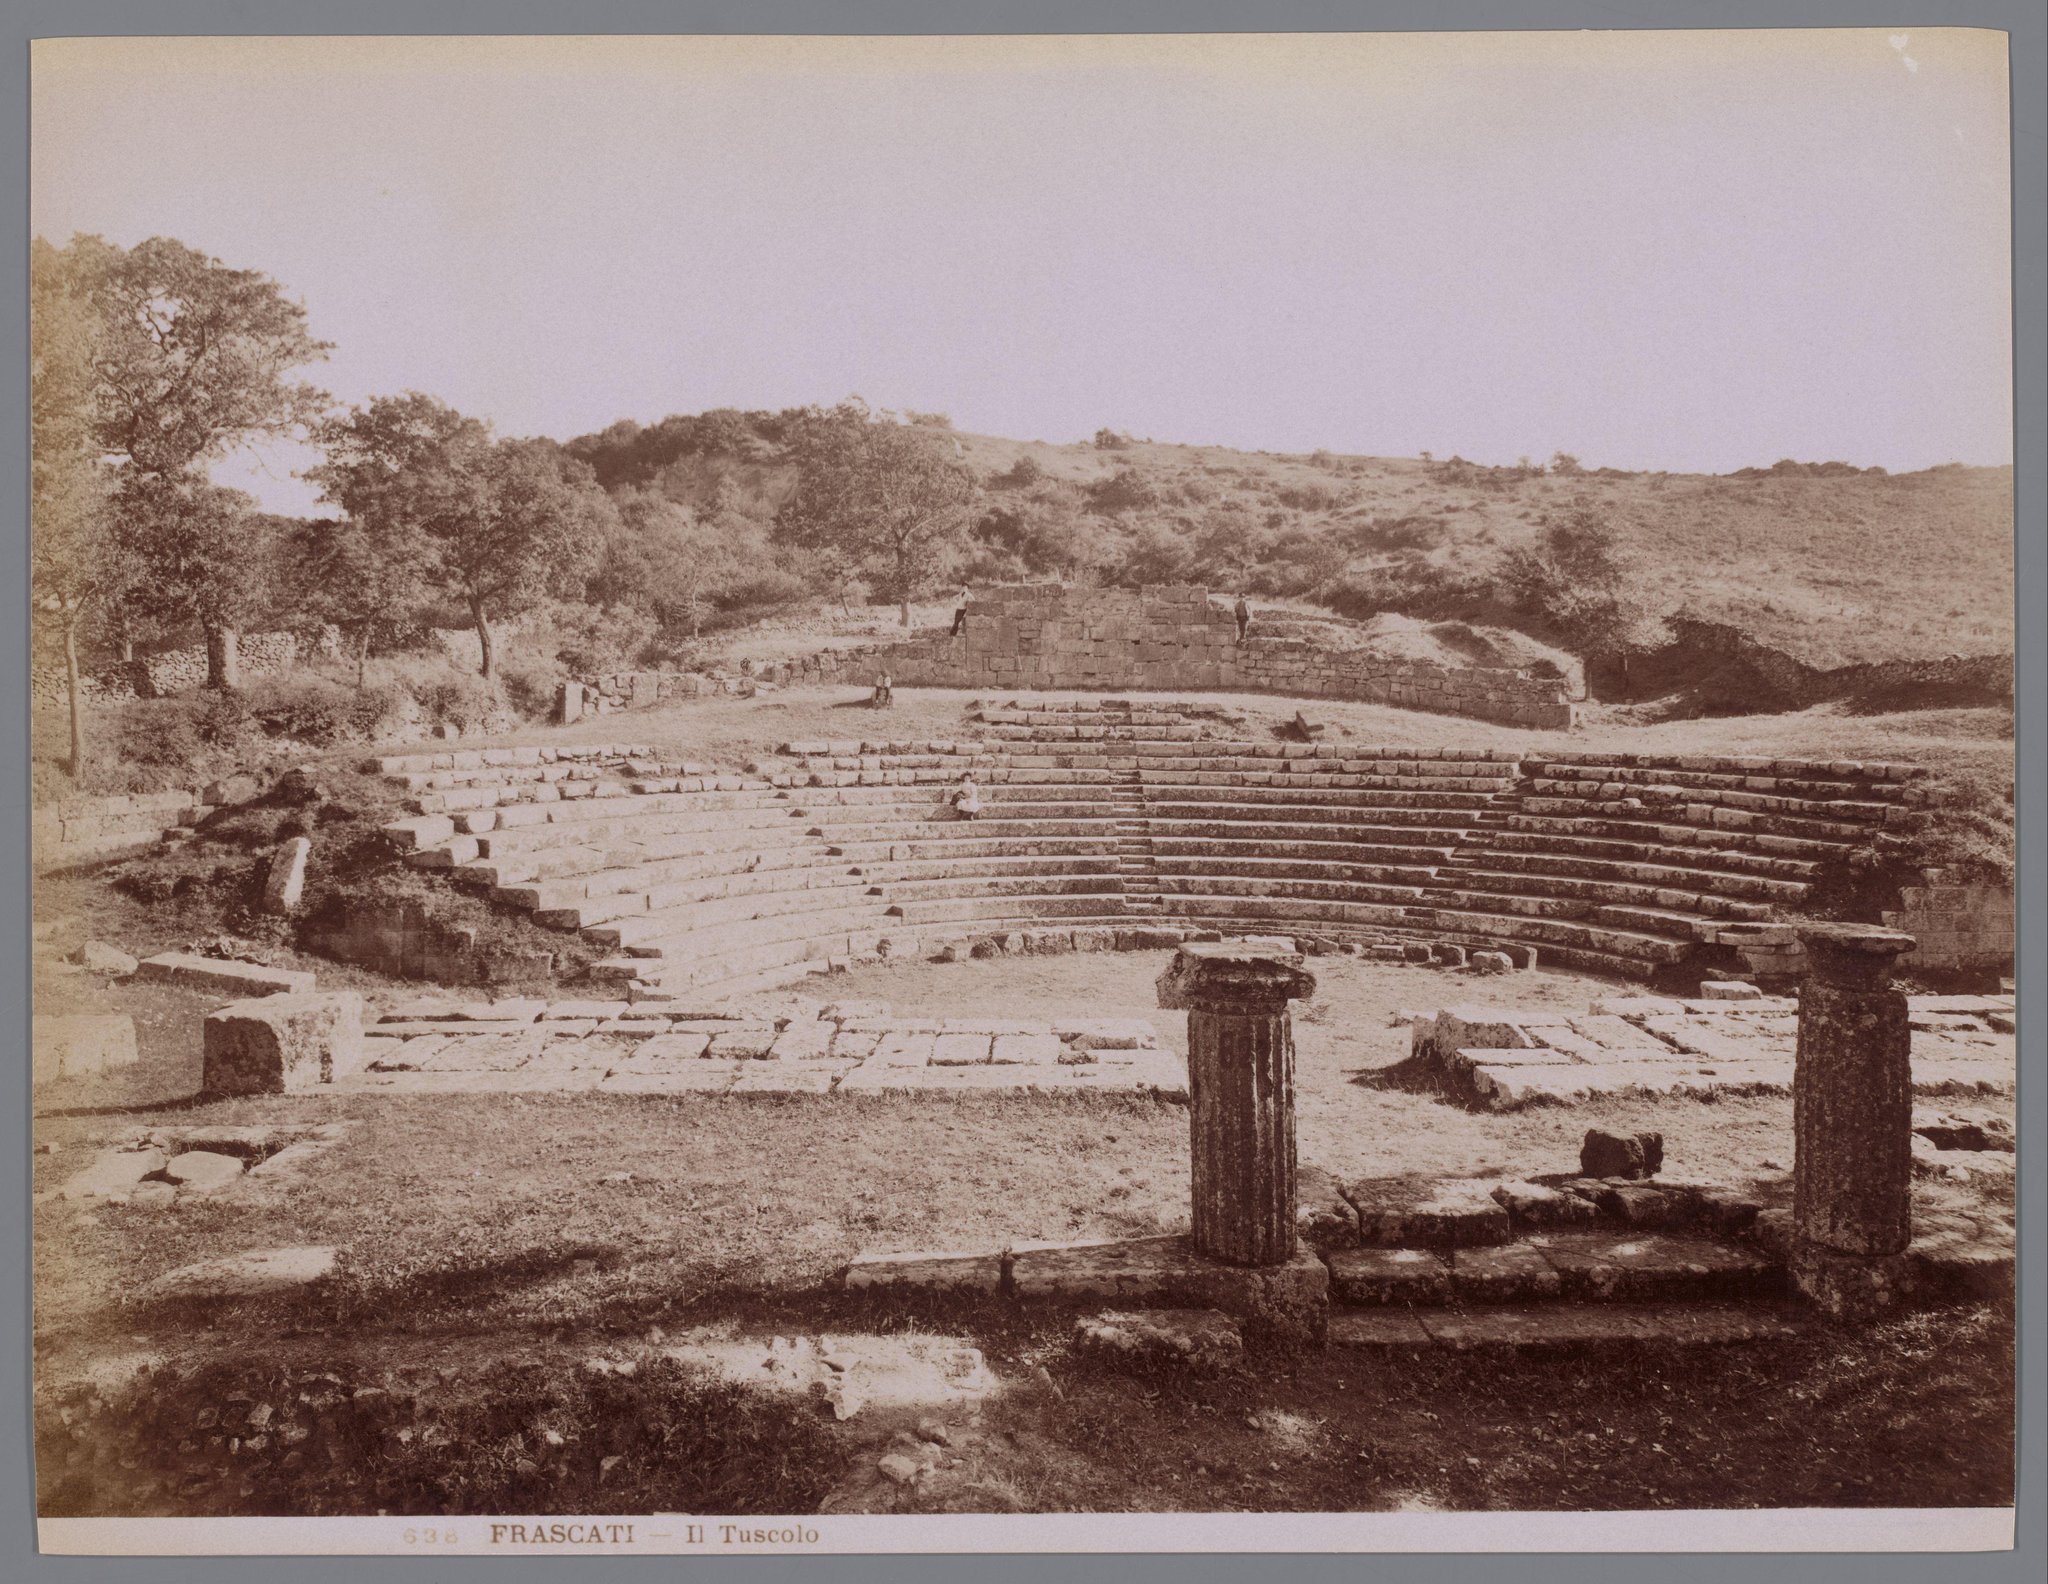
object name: photograph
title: Amfitheater van Tusculum nabij Frascati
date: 1860-1900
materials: paper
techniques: albumen print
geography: tusculum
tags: amphitheatre, landscape with ruins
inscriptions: collector's mark: ‘VOSMAER’, number: ‘638’